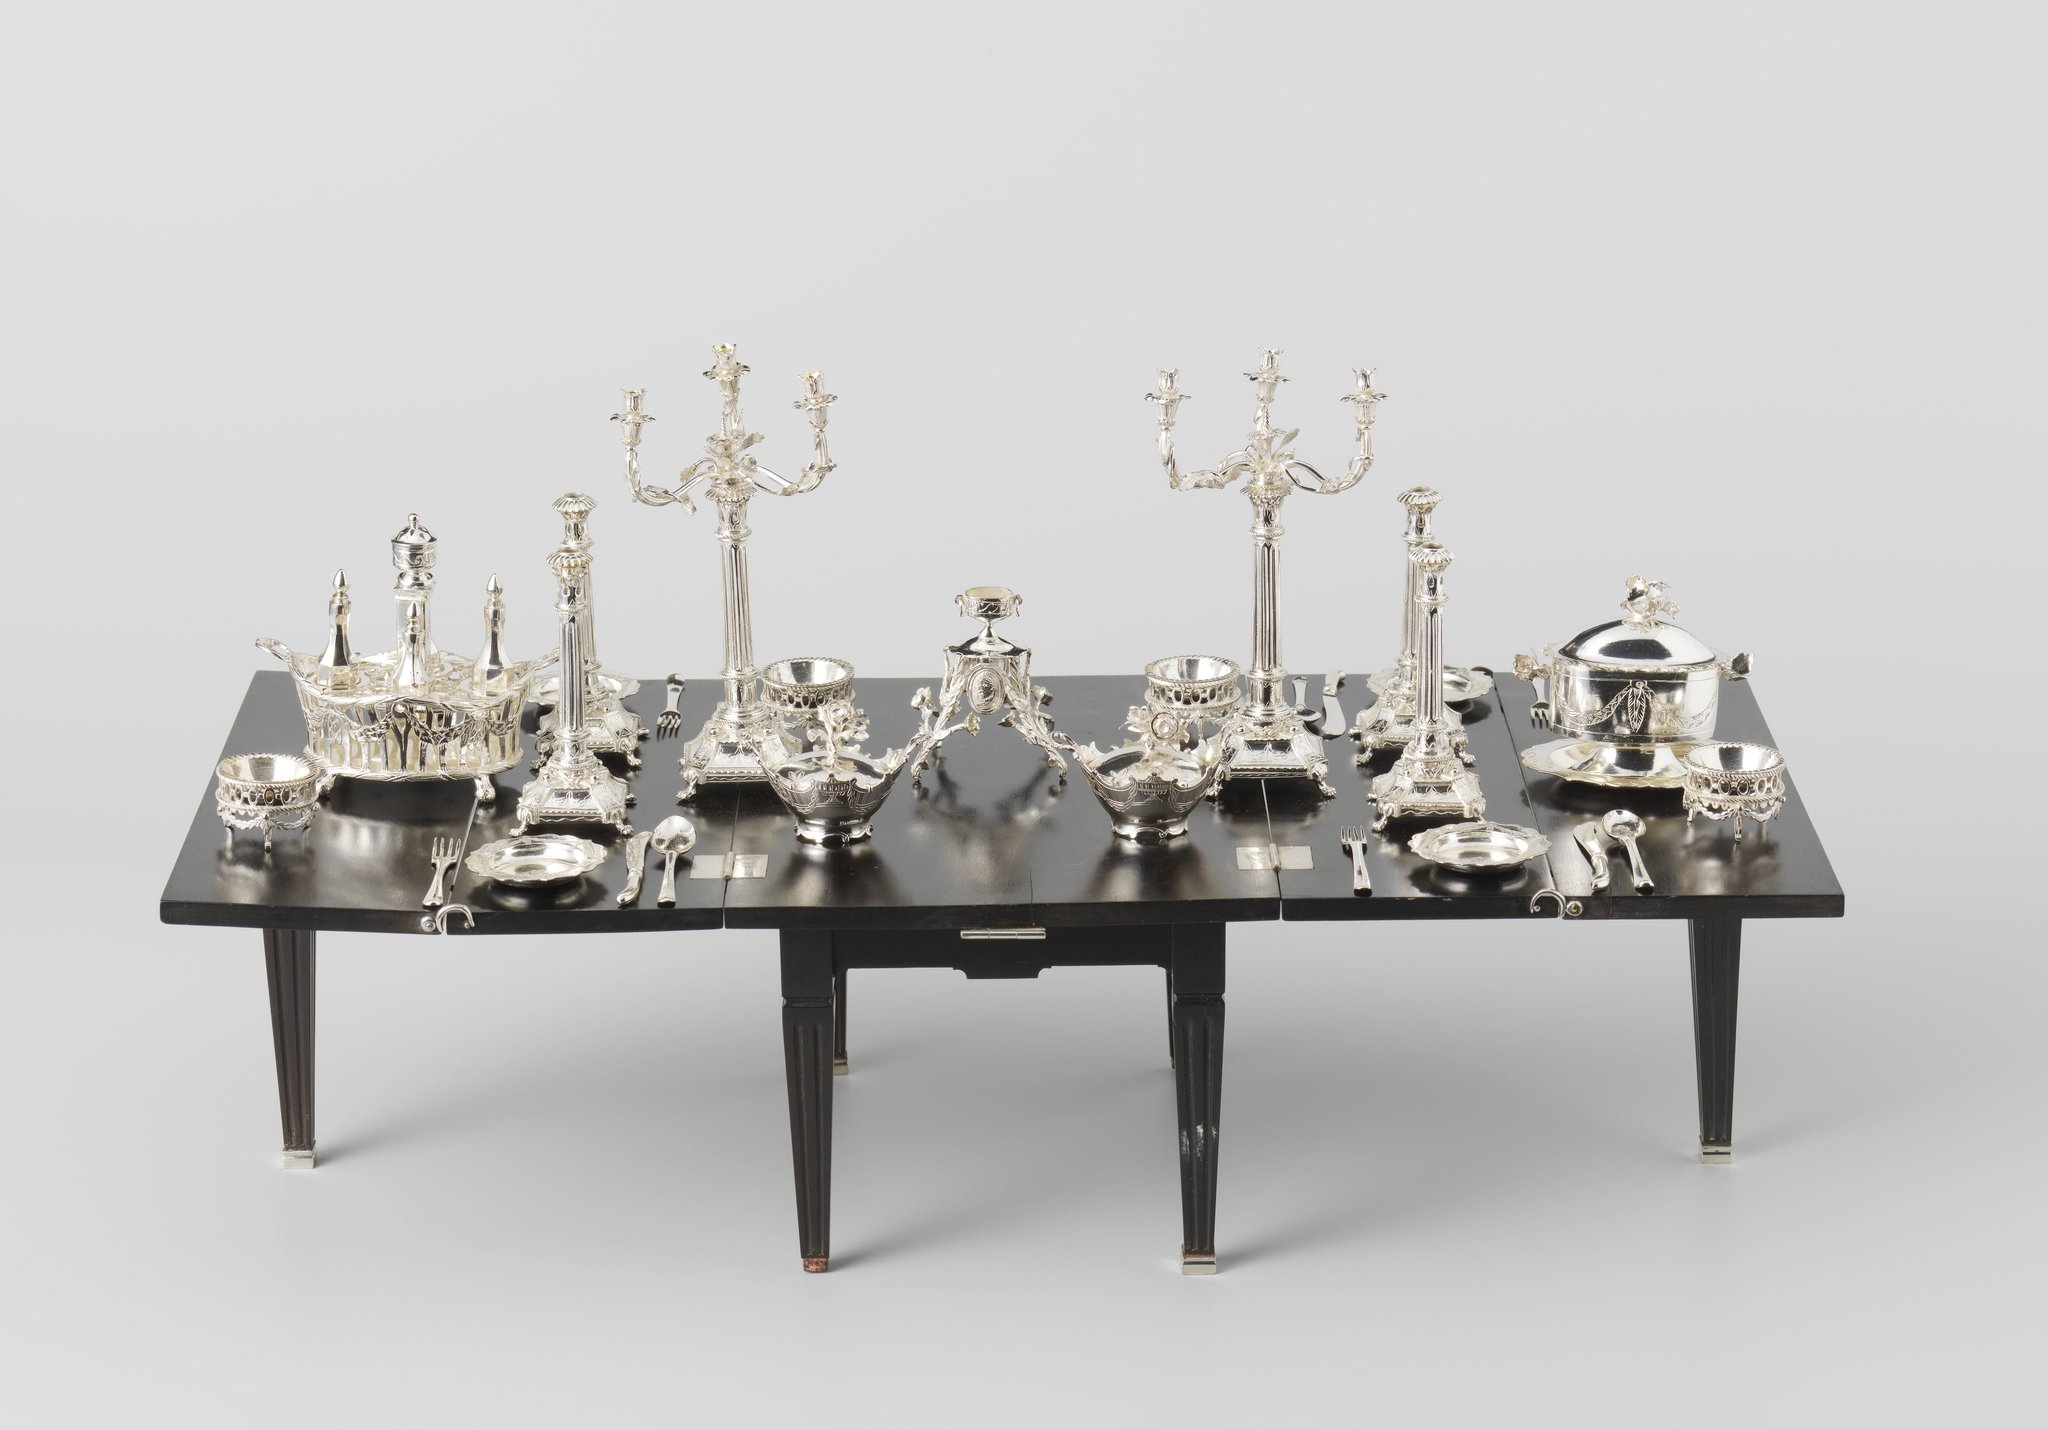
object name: miniature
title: Desserttrommel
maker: hendrik duller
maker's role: silversmith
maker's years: 1749-1820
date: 1789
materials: silver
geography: amsterdam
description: Ronde trommel met een gewelfde deksel. De knop van het deksel wordt gevormd door een bloementak. Op de wanden van de trommel zijn guirlandes gegraveerd. De trommel is gemerkt: stk.= Amsterdam, jrl.= E (1789) en mt.= Hendrik Duller. De trommel hoort bij een rechthoekige trommel met invnr. BK-NM-11177-256.